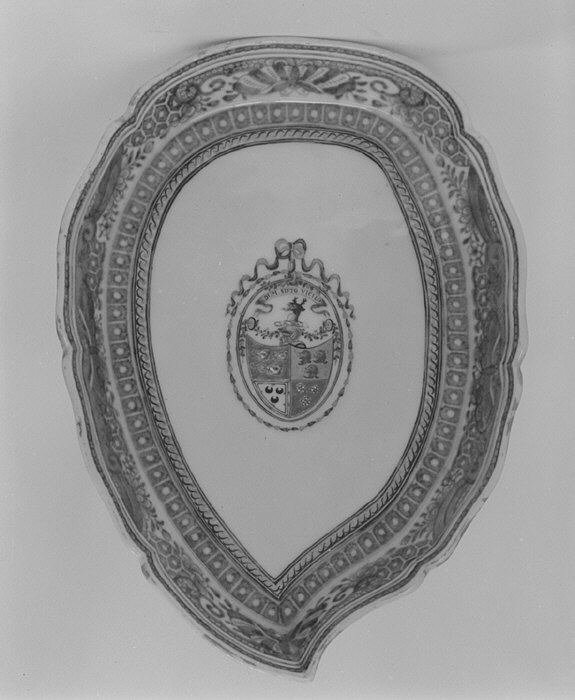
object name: sauceboat tray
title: Sauceboat tray (part of a service)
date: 1770-1785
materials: hard paste porcelain